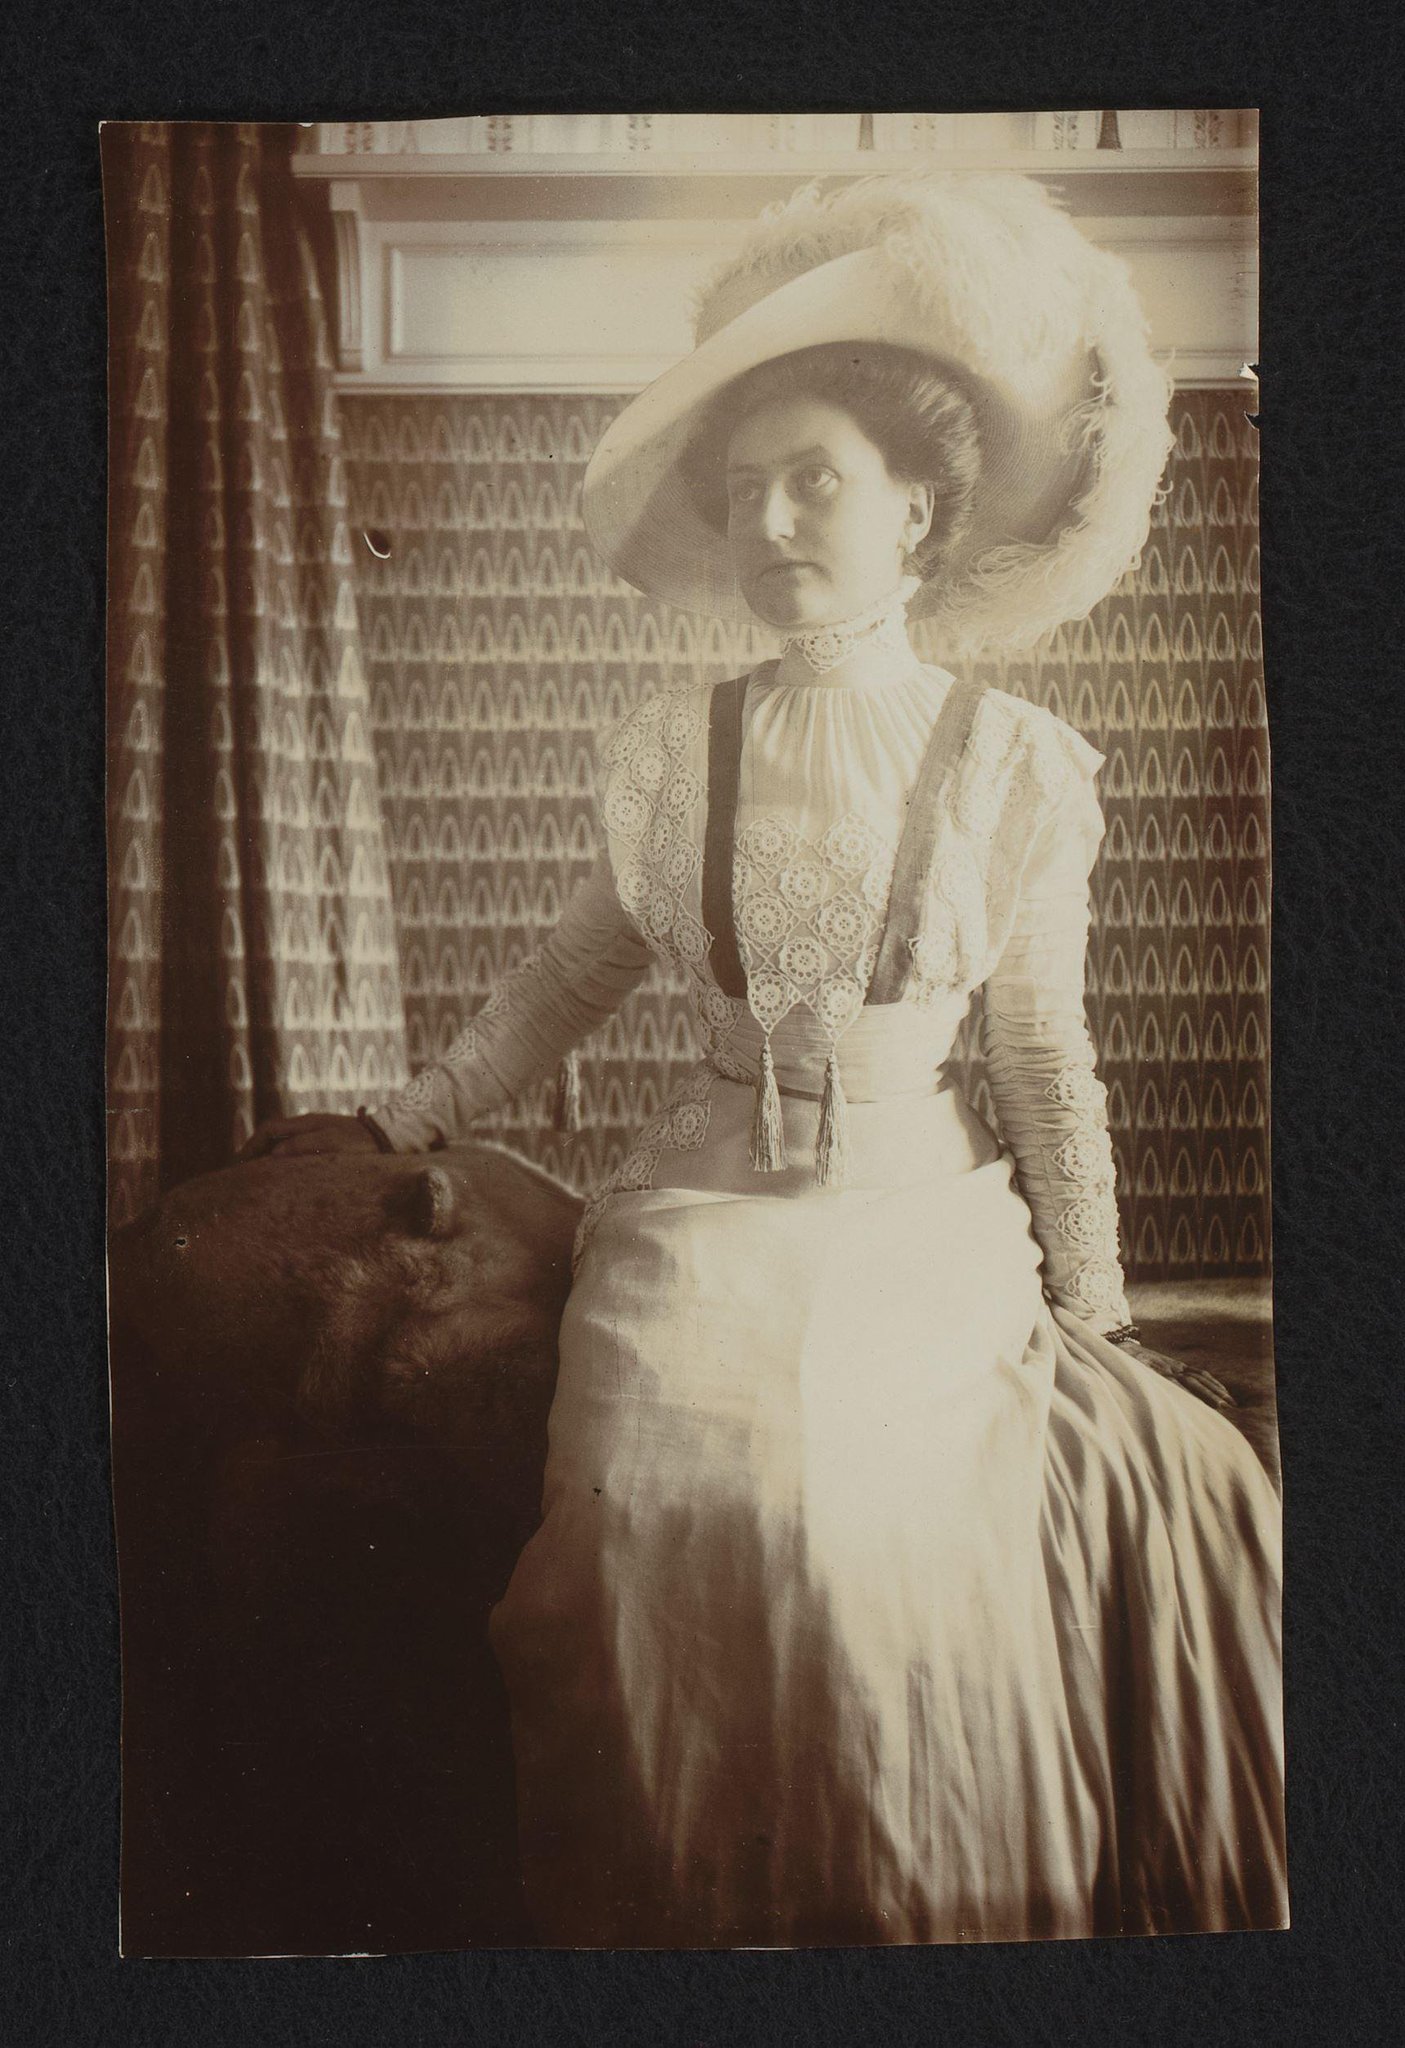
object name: photograph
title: Portret van een zittende vrouw in interieur, met hoed en kanten blouse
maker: Anonymous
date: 1900-1915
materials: cardboard, photographic support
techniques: collodion silver print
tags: historical persons - bb - woman, head-gear: hat, interior of the house